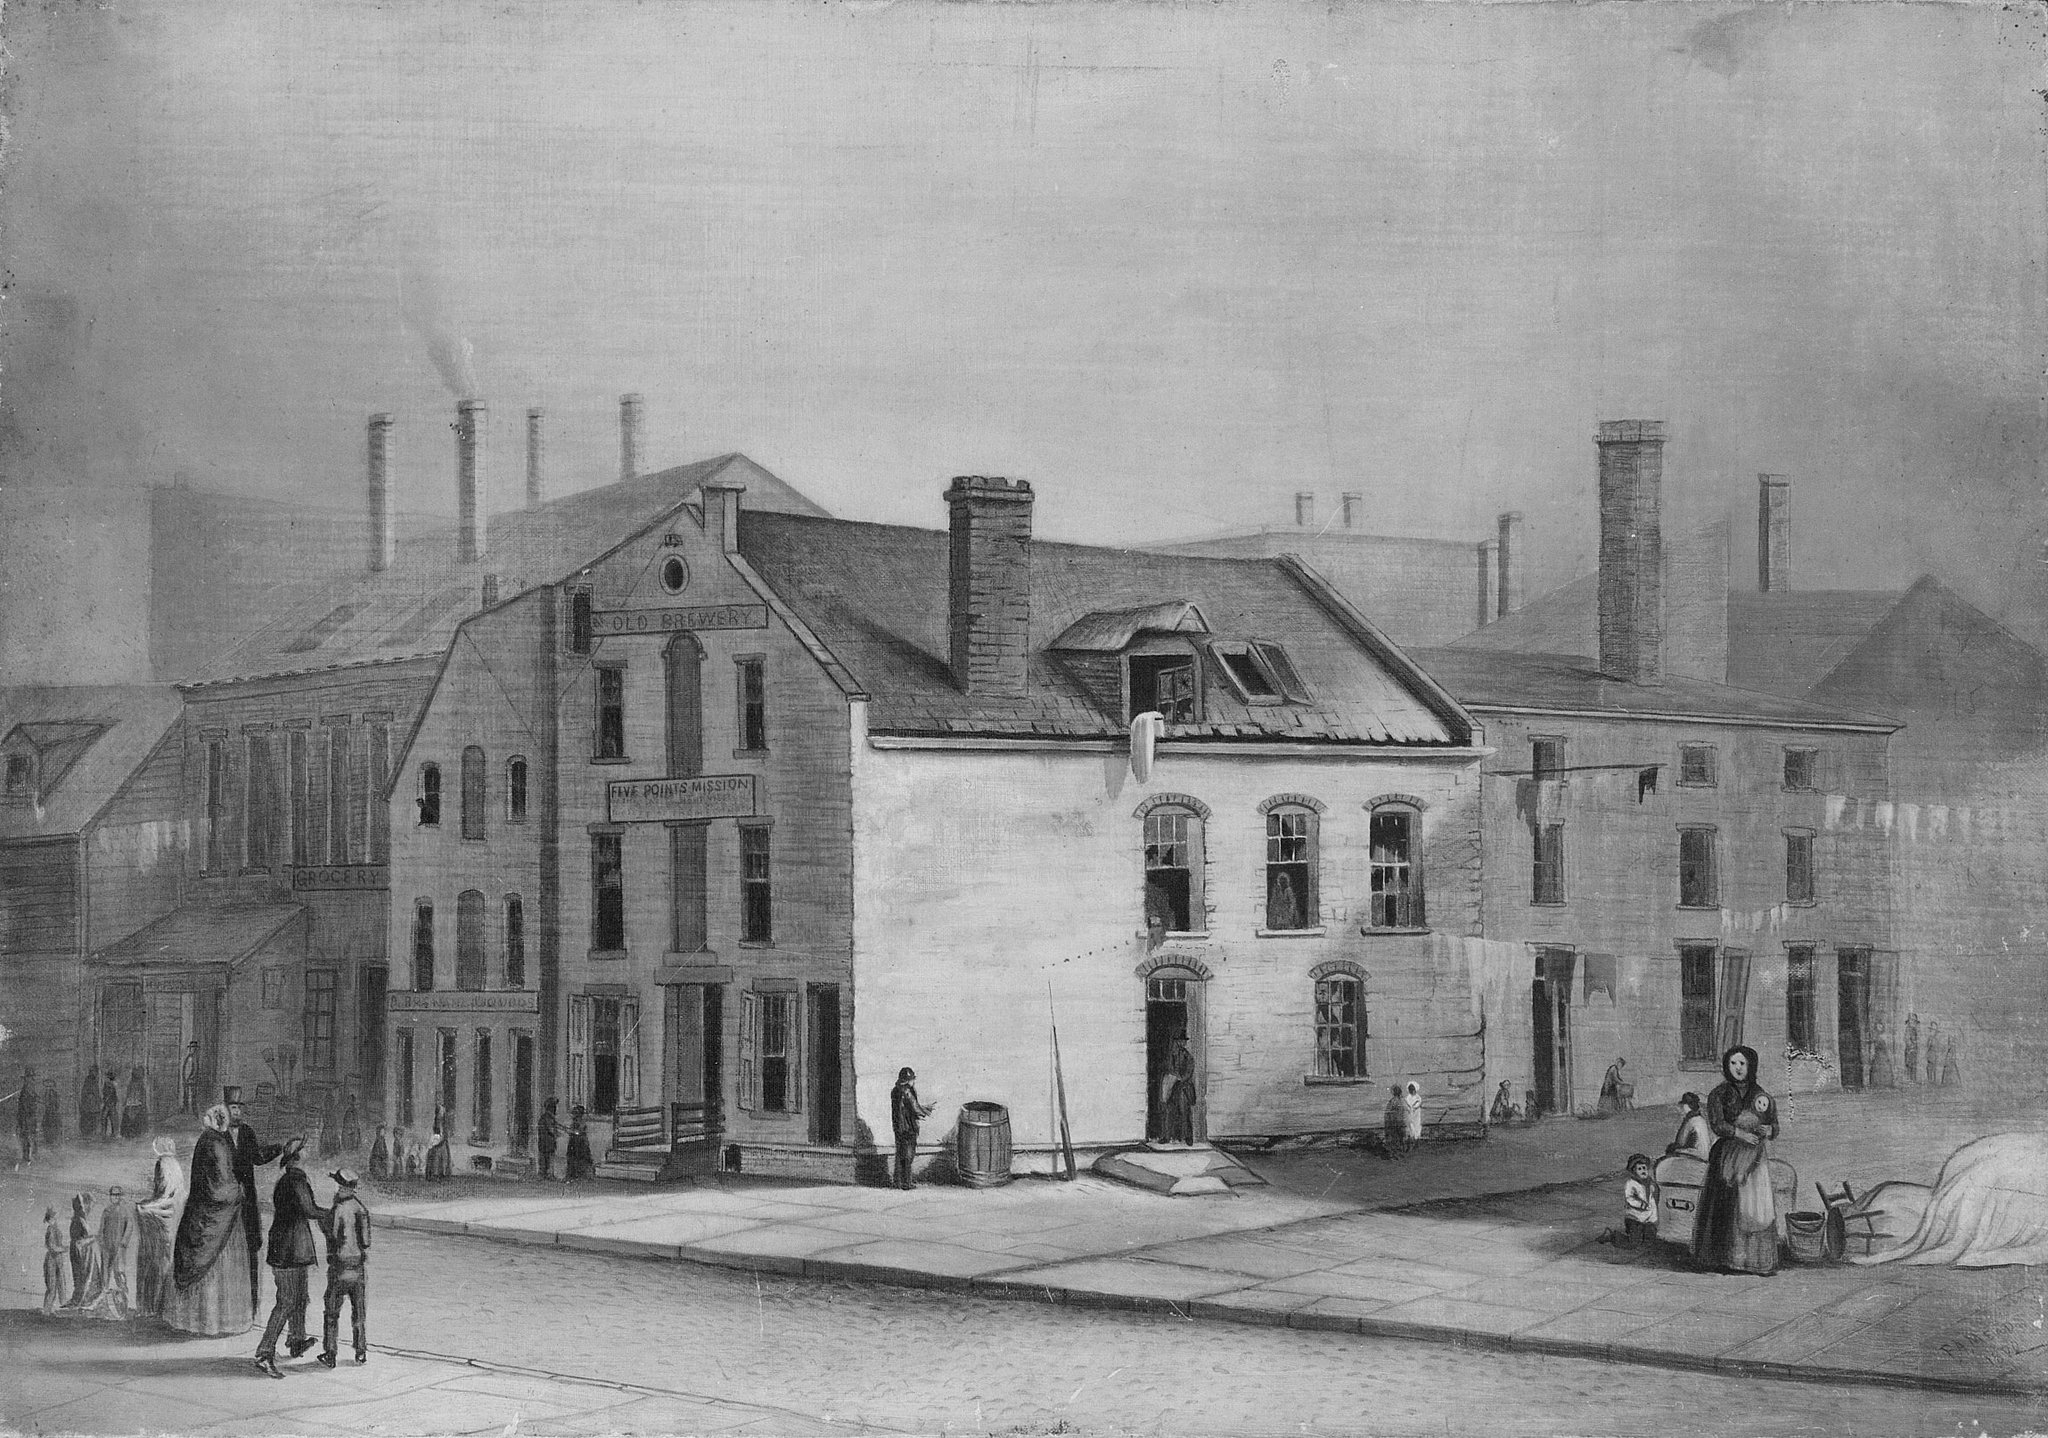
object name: painting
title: Old Brewery, Five Points Mission, New York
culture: american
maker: f. a. mead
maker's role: artist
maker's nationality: american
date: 1870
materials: canvas, oil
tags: human figures,factories,cities,roads,new york city